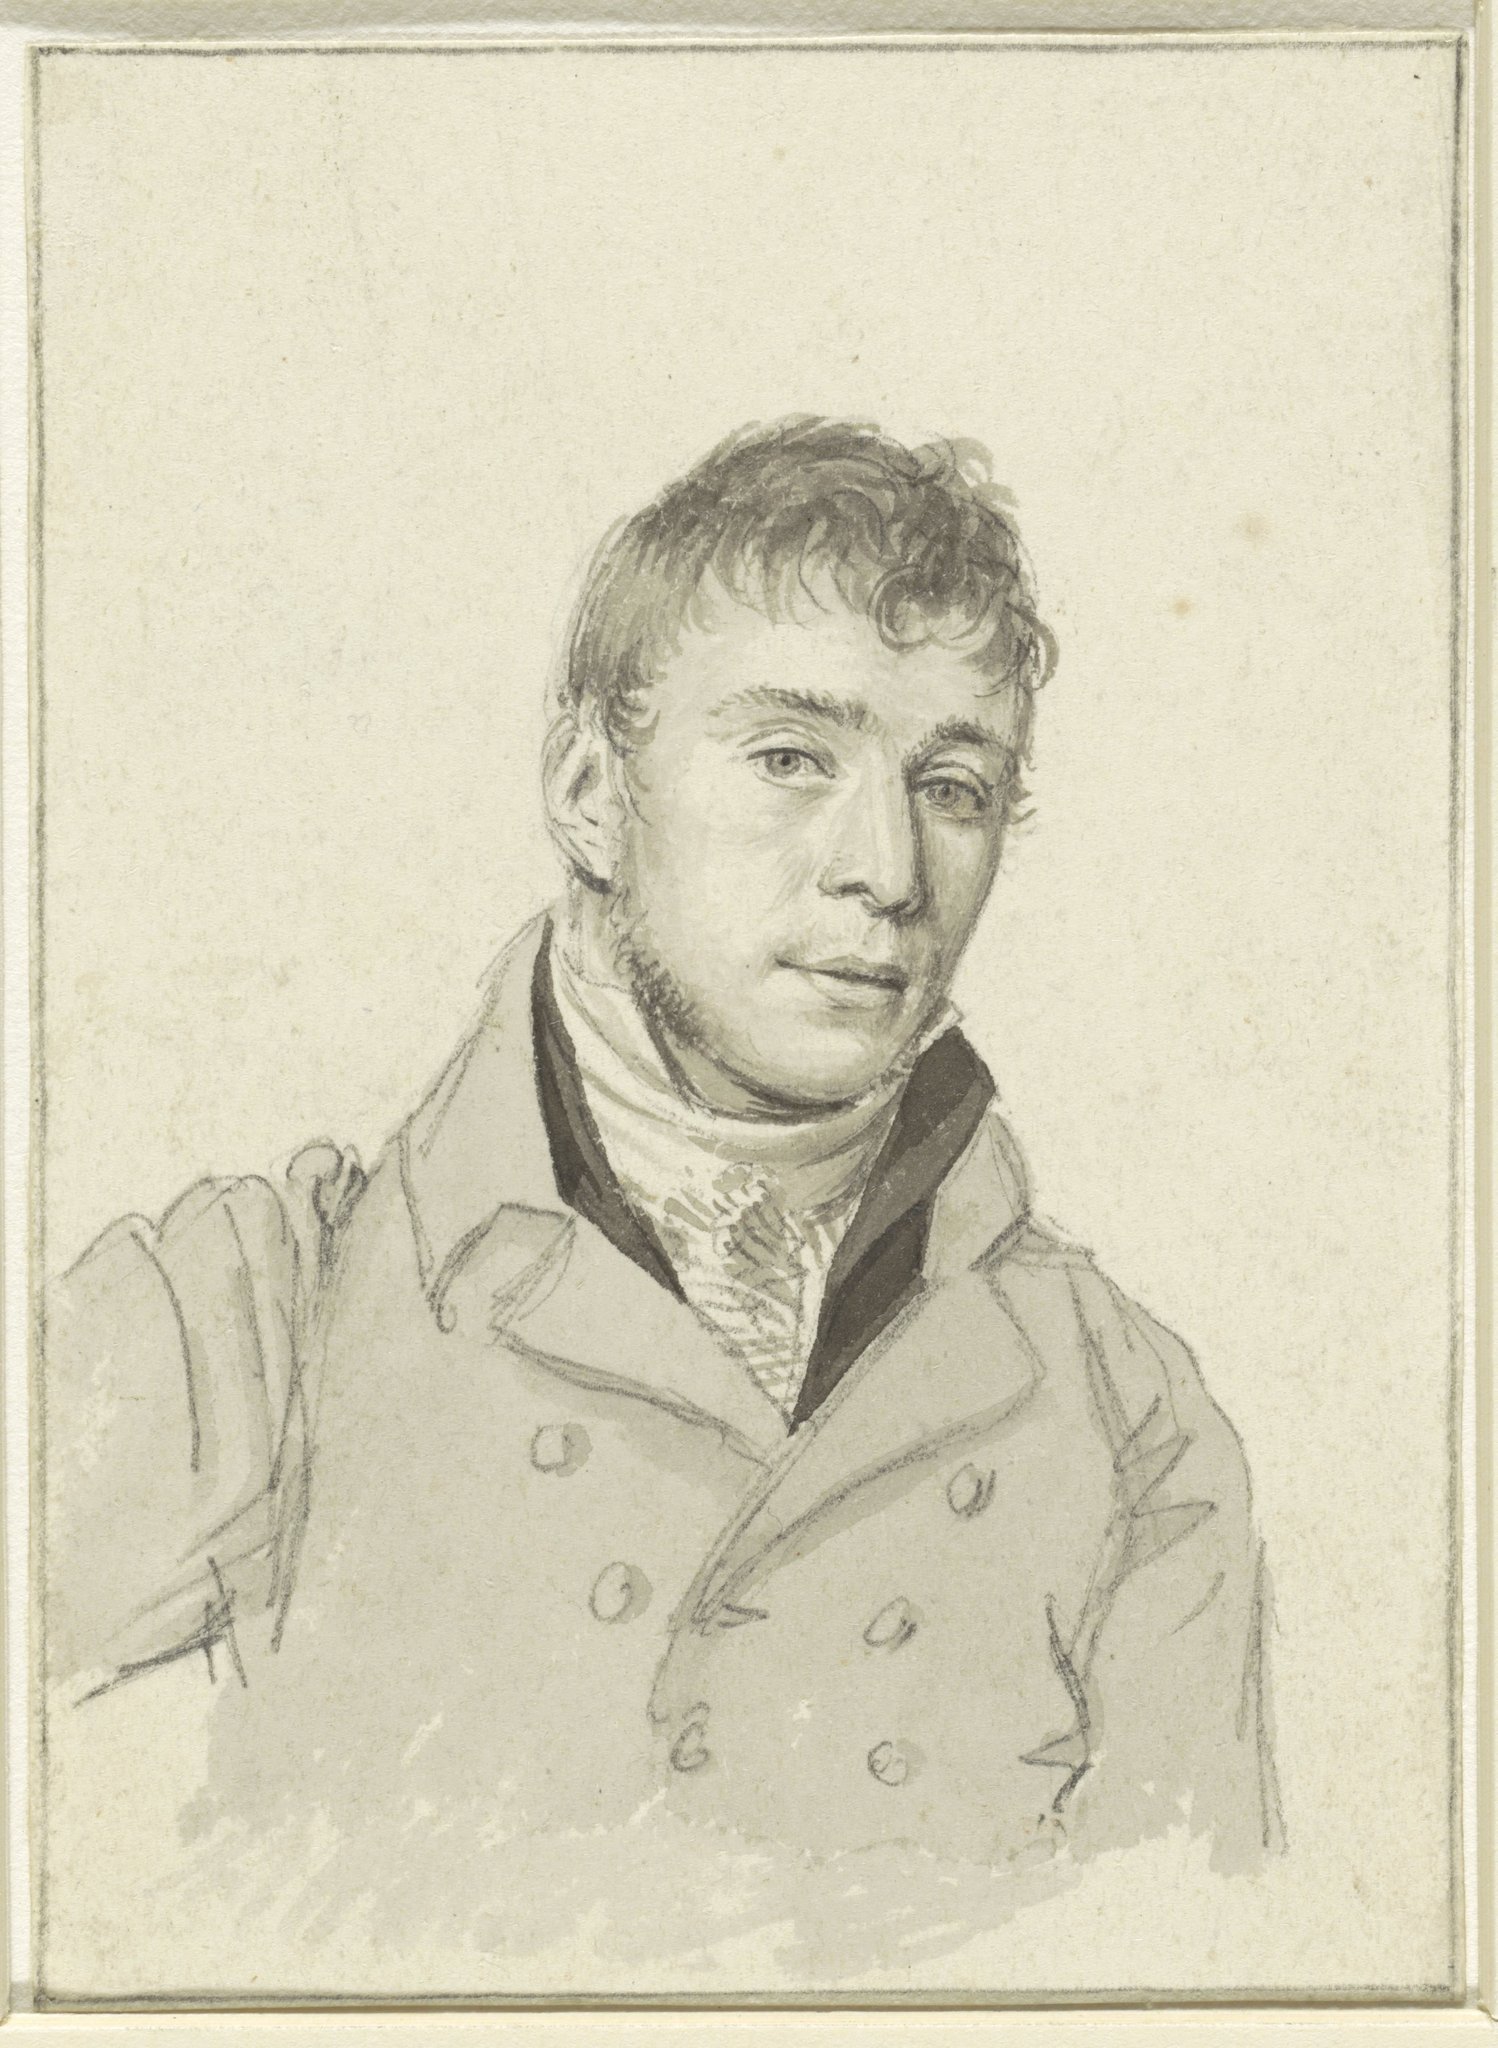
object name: drawing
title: Portret van Johan Christiaan Willem Saft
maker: hendrik willem caspari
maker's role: draughtsman, print maker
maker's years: 1770-1829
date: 1780-1829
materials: paper, pencil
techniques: brush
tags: johan christiaan willem safft, historical persons, portrait, self-portrait of artist